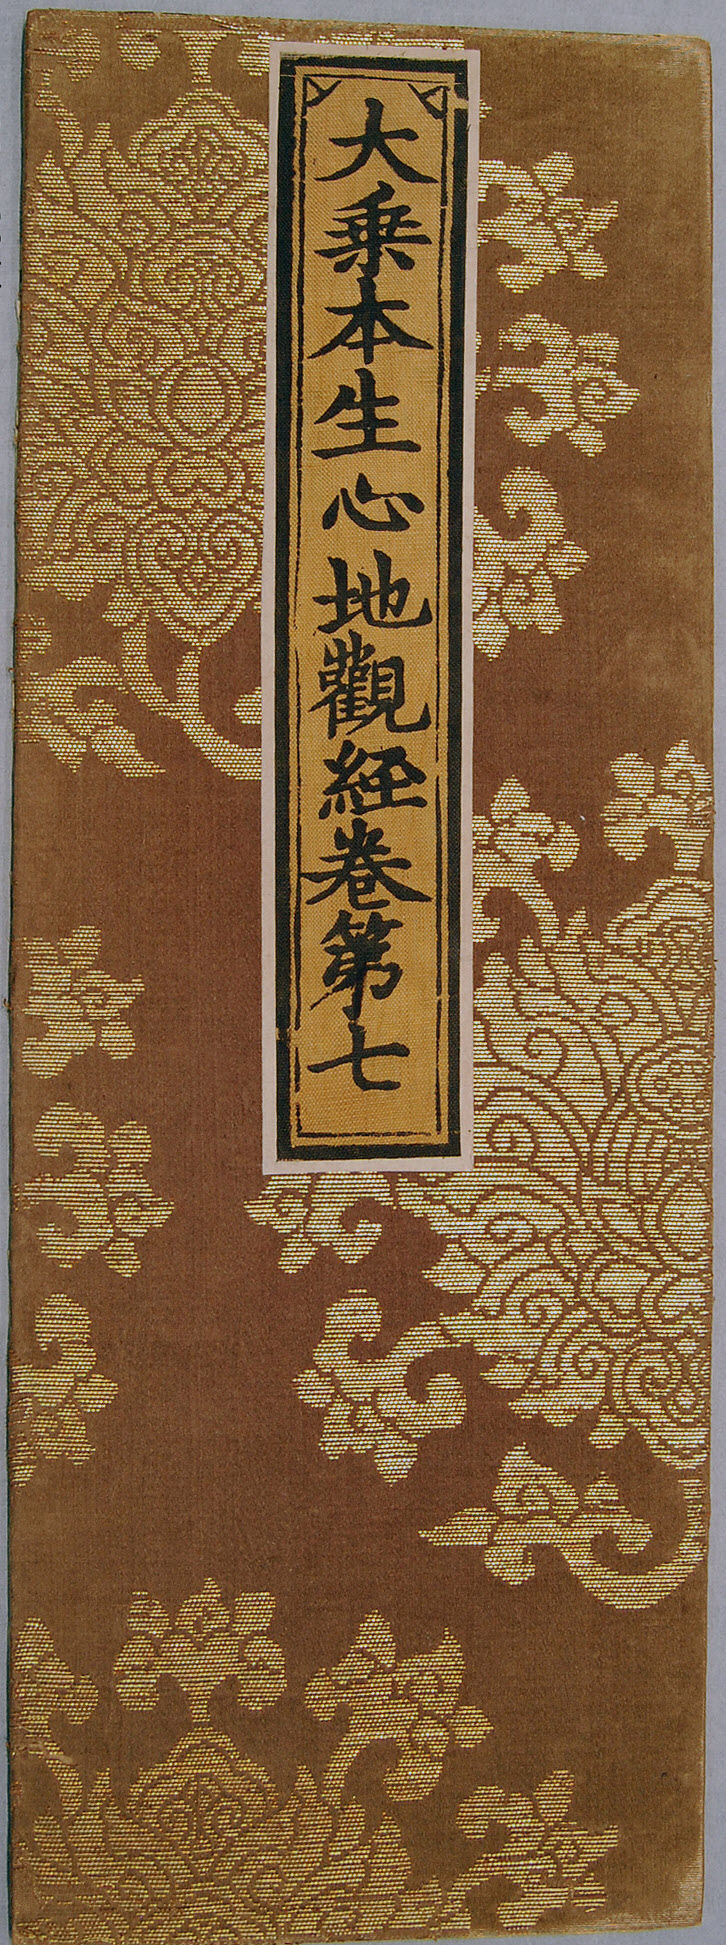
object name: sutra cover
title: Sutra Cover with Floral Medallions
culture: chinese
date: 1501-1600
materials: silk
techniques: patterning, weave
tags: flowers